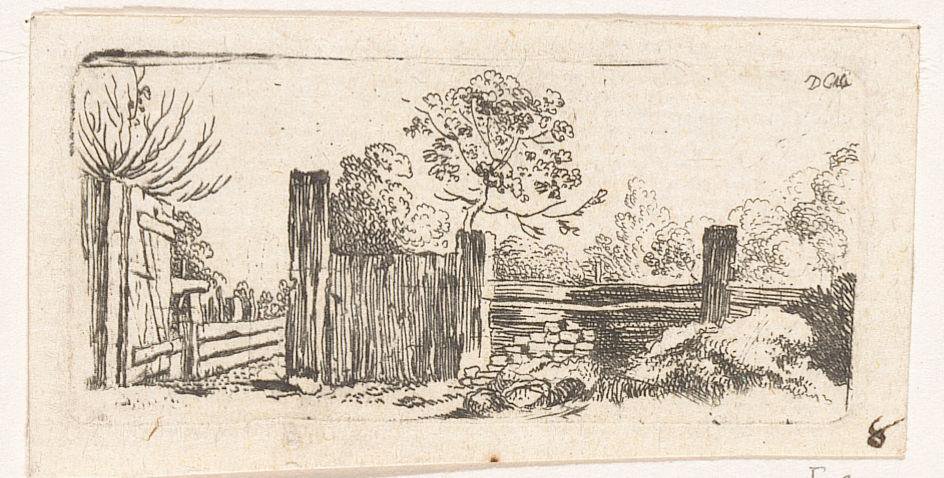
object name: print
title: Landschapsstudie met open hek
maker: daniel nikolaus chodowiecki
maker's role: draughtsman, print maker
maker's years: 1726-1801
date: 1764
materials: paper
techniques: etching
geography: berlin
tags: landscapes, gate, entrance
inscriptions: collector's mark: Lugt 2228, number: ‘8’